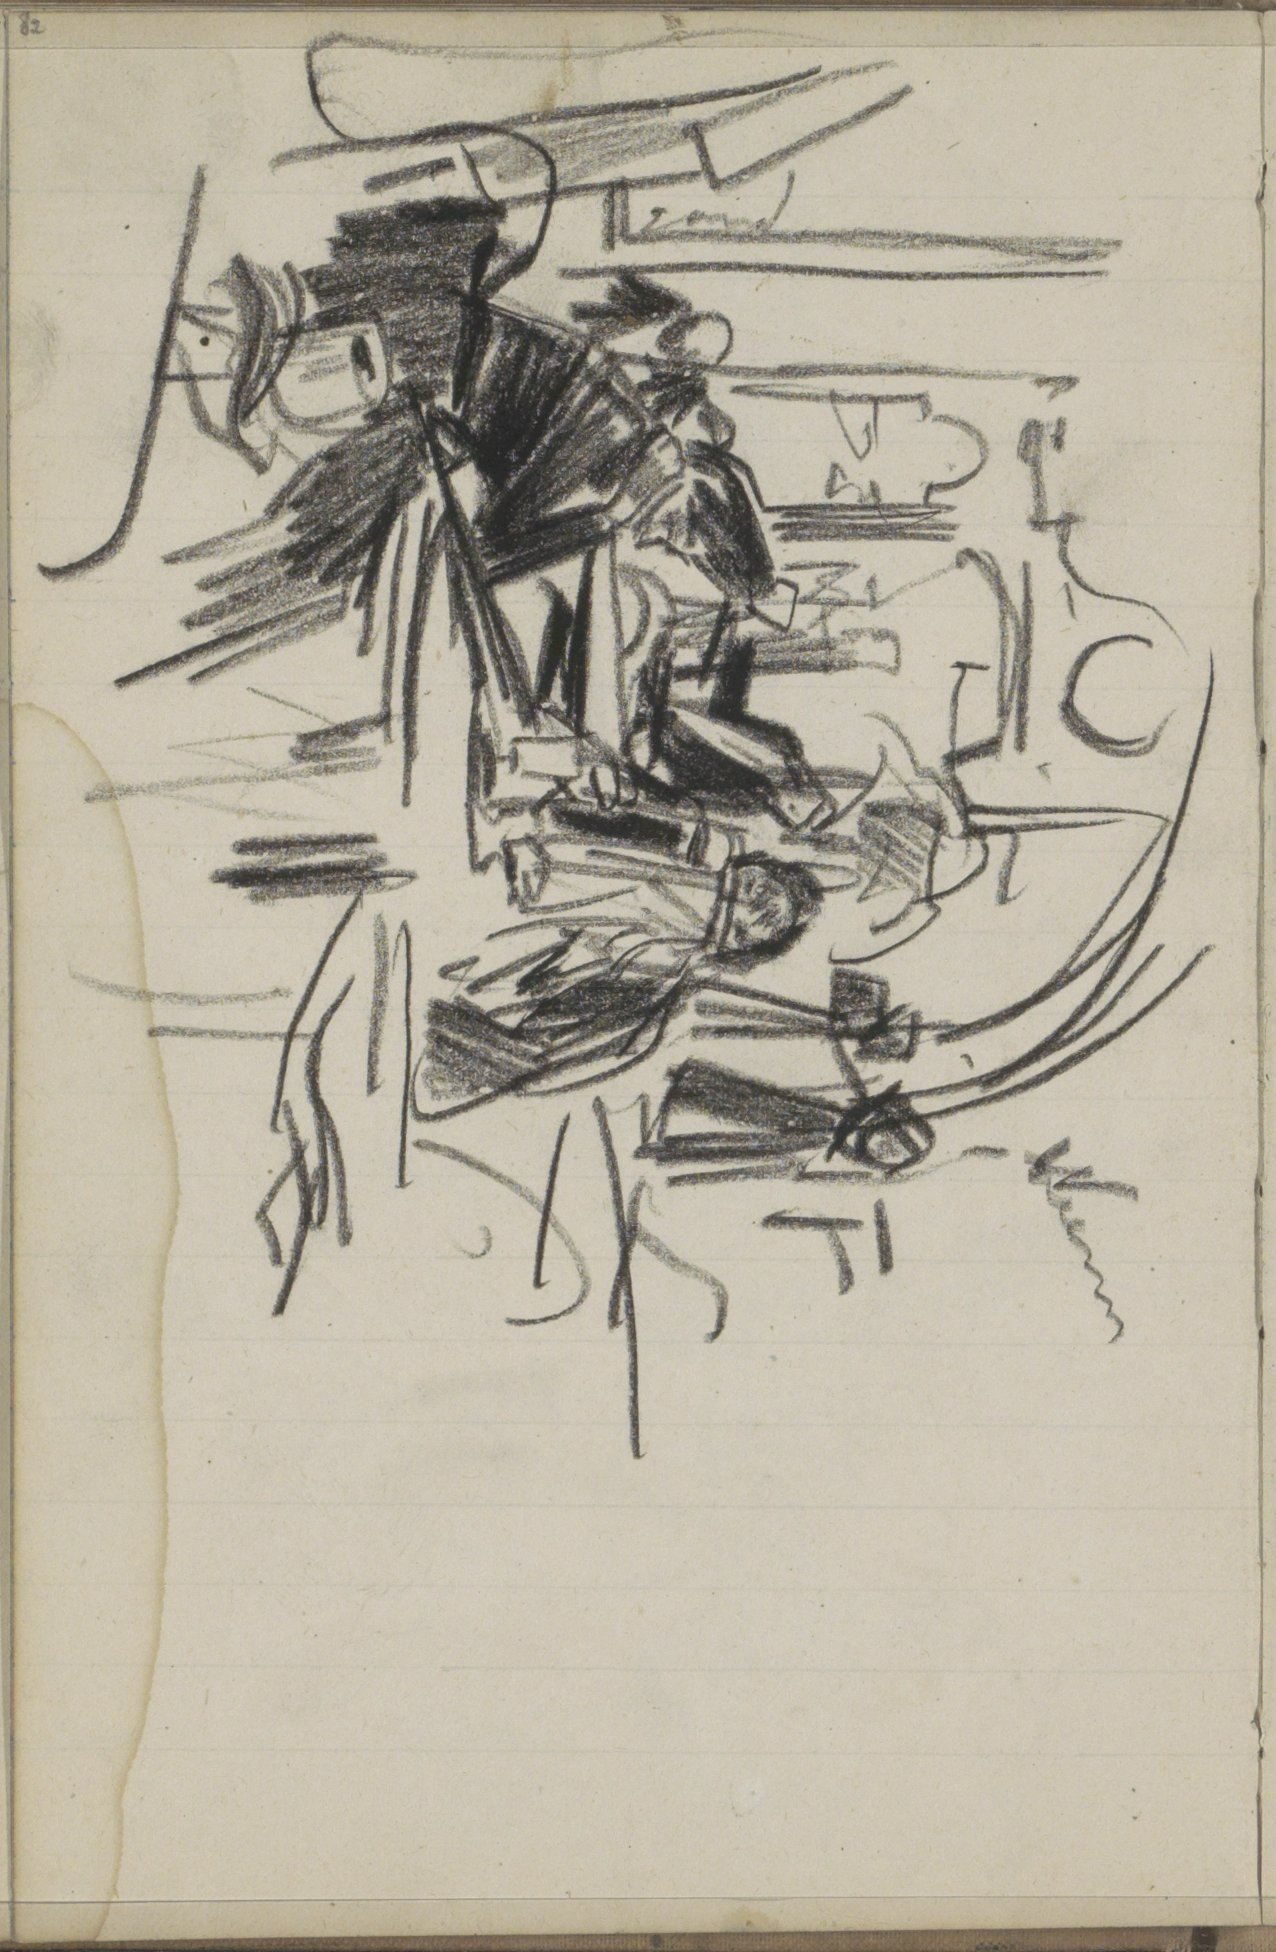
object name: sketchbook leaf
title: Café of koffiehuis in Wenen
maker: marius bauer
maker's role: draughtsman, print maker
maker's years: 1867-1932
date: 1888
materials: chalk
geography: vienna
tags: sitting figure, inn, coffee-house, public house, etc., vienna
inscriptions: annotation: ‘Weenen’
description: Met verschillende figuren aan tafels. Pagina 82 uit een schetsboek met 49 bladen.